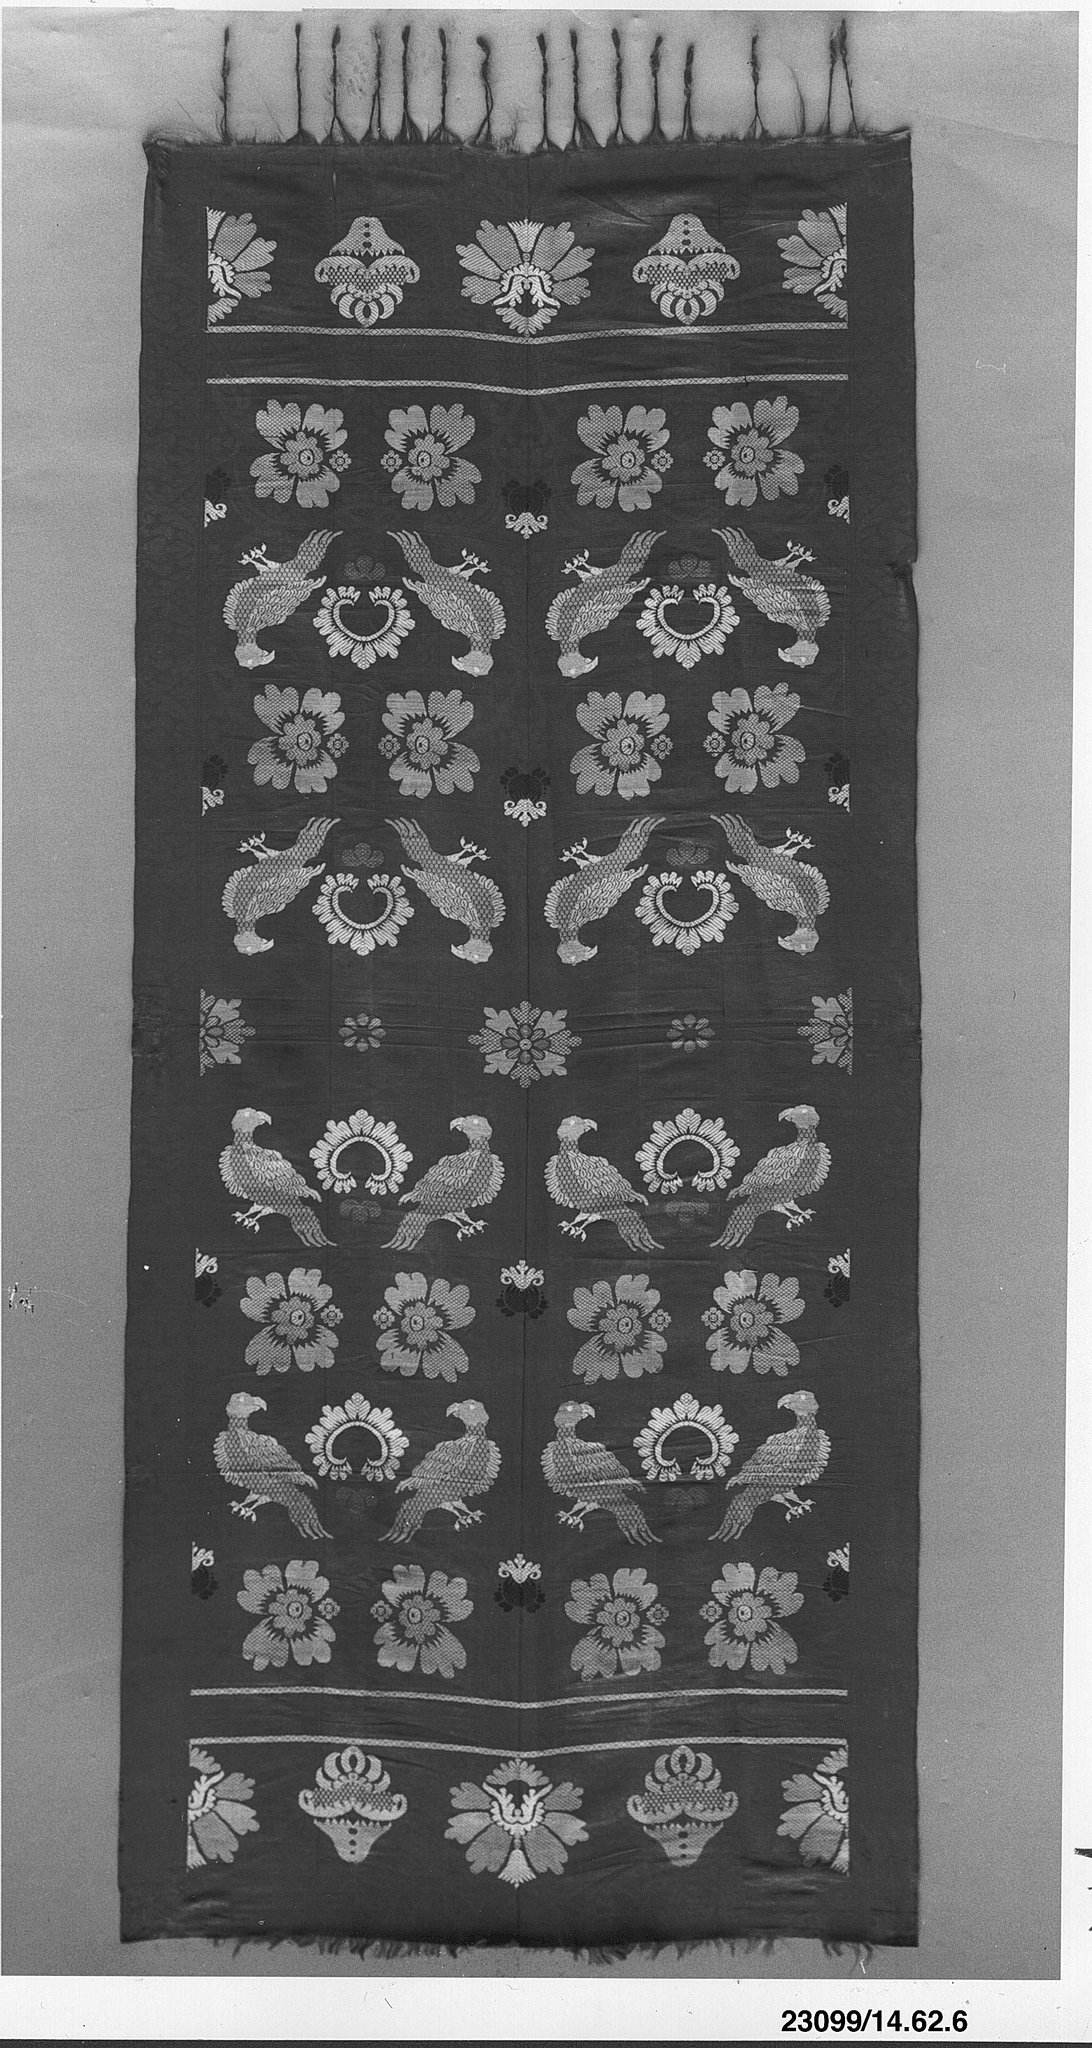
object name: cover or scarf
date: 1701-1800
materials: metal thread, silk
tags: birds,flowers